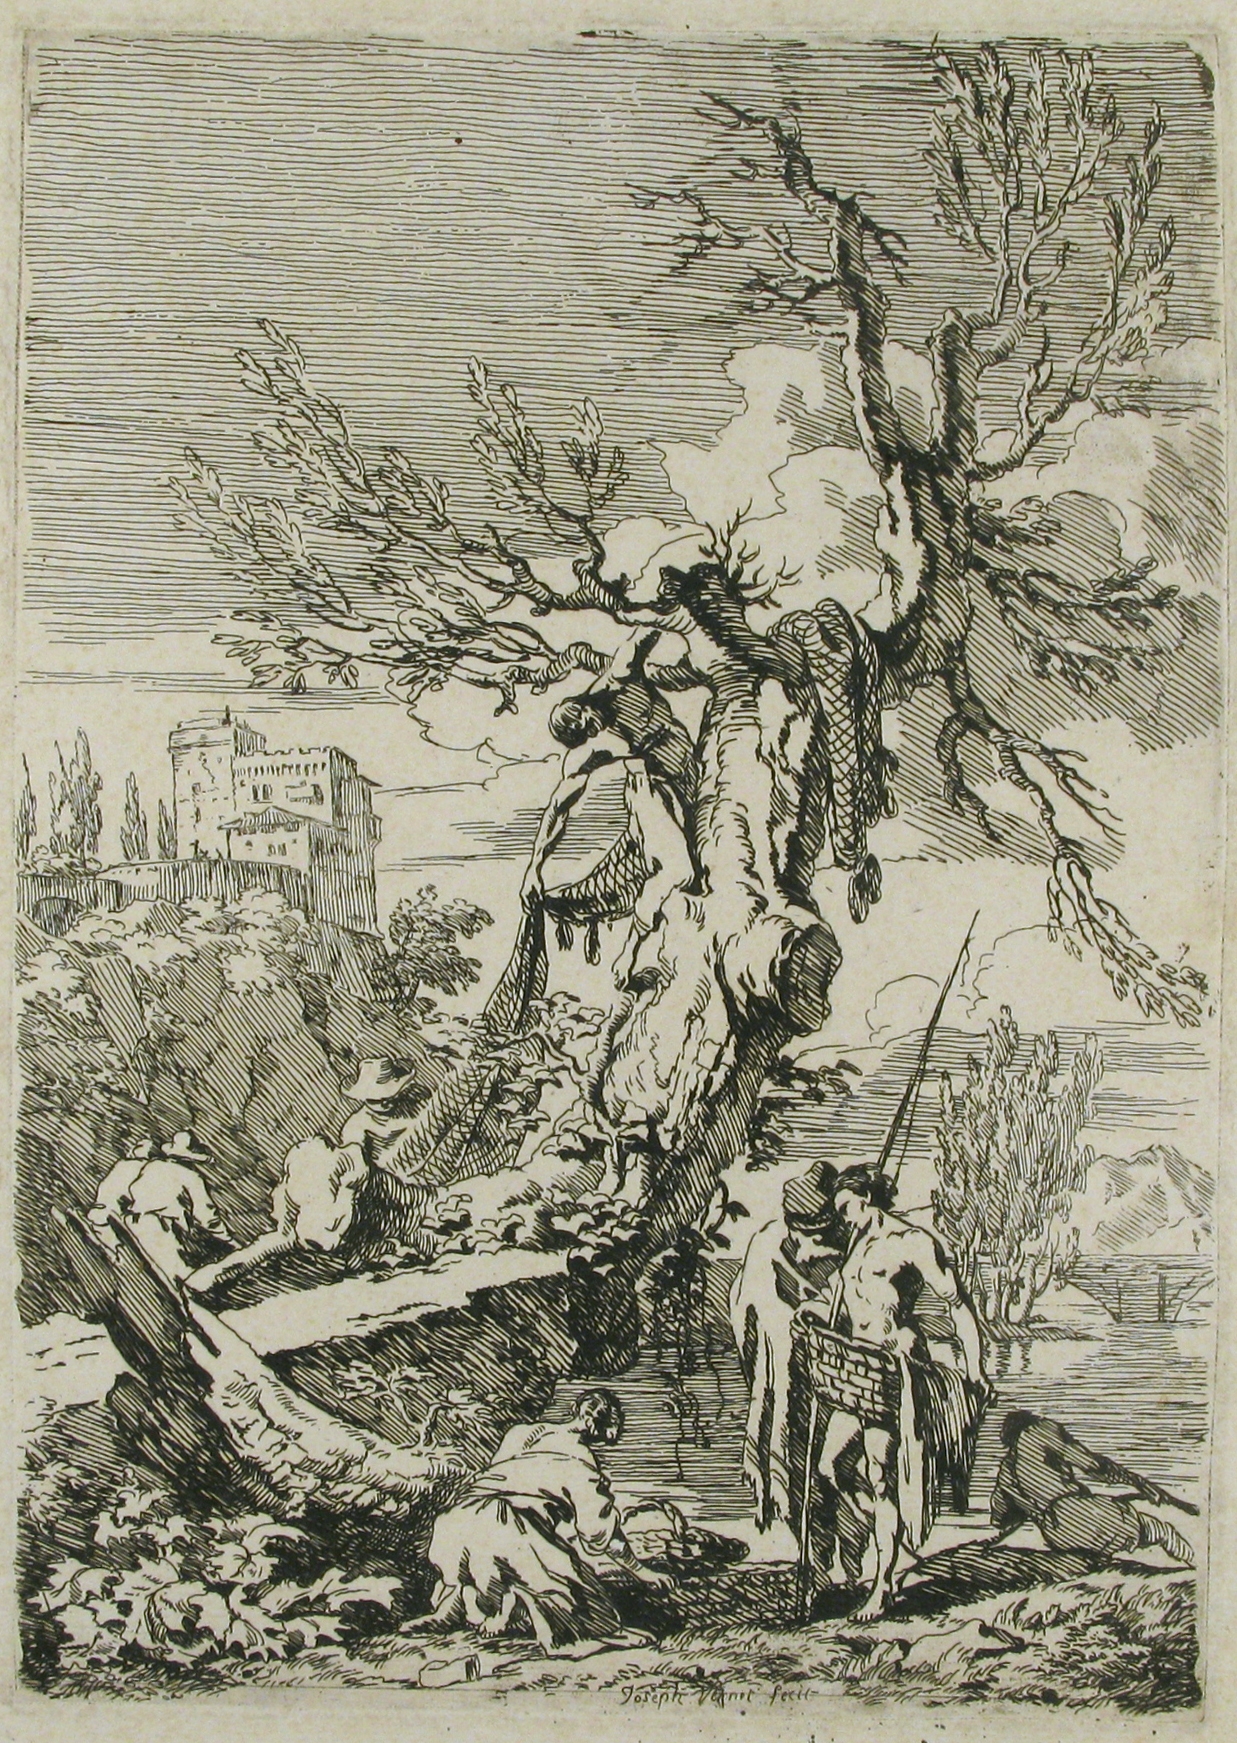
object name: print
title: Retour de la Pêche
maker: joseph vernet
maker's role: artist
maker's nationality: french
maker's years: 1714-1789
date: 1701-1800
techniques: etching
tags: men,trees